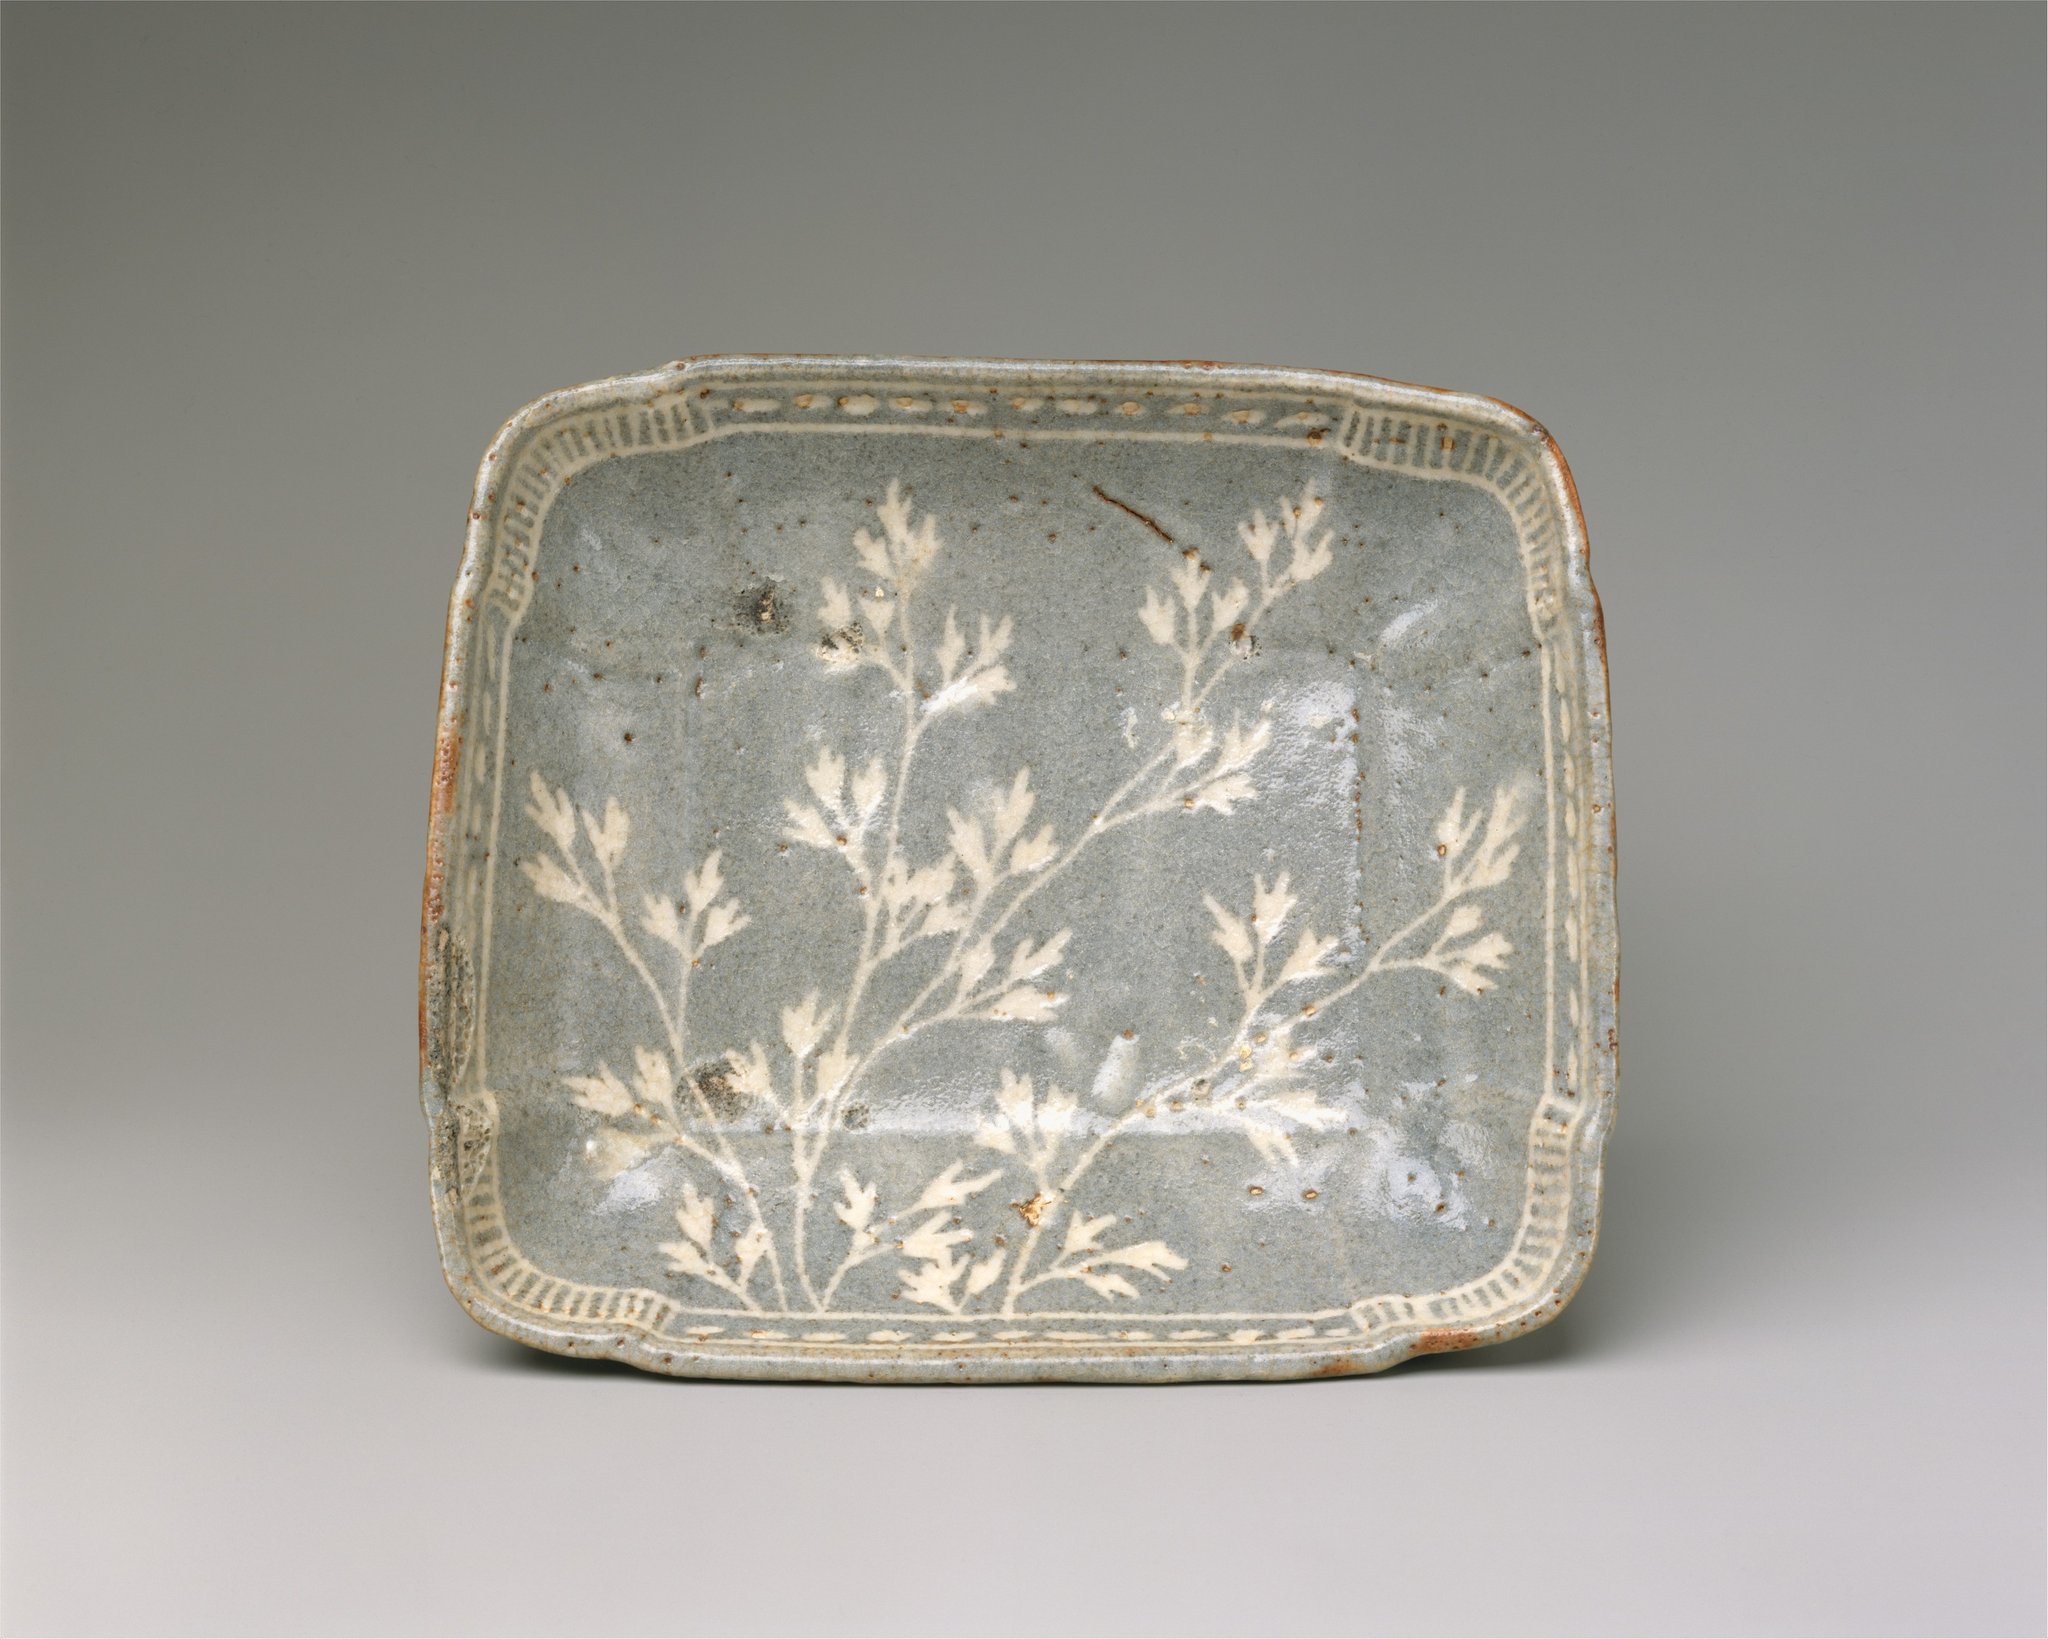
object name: dish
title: Dish with Grasses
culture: japanese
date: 1567-1633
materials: clay, iron, stoneware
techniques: incising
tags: plants